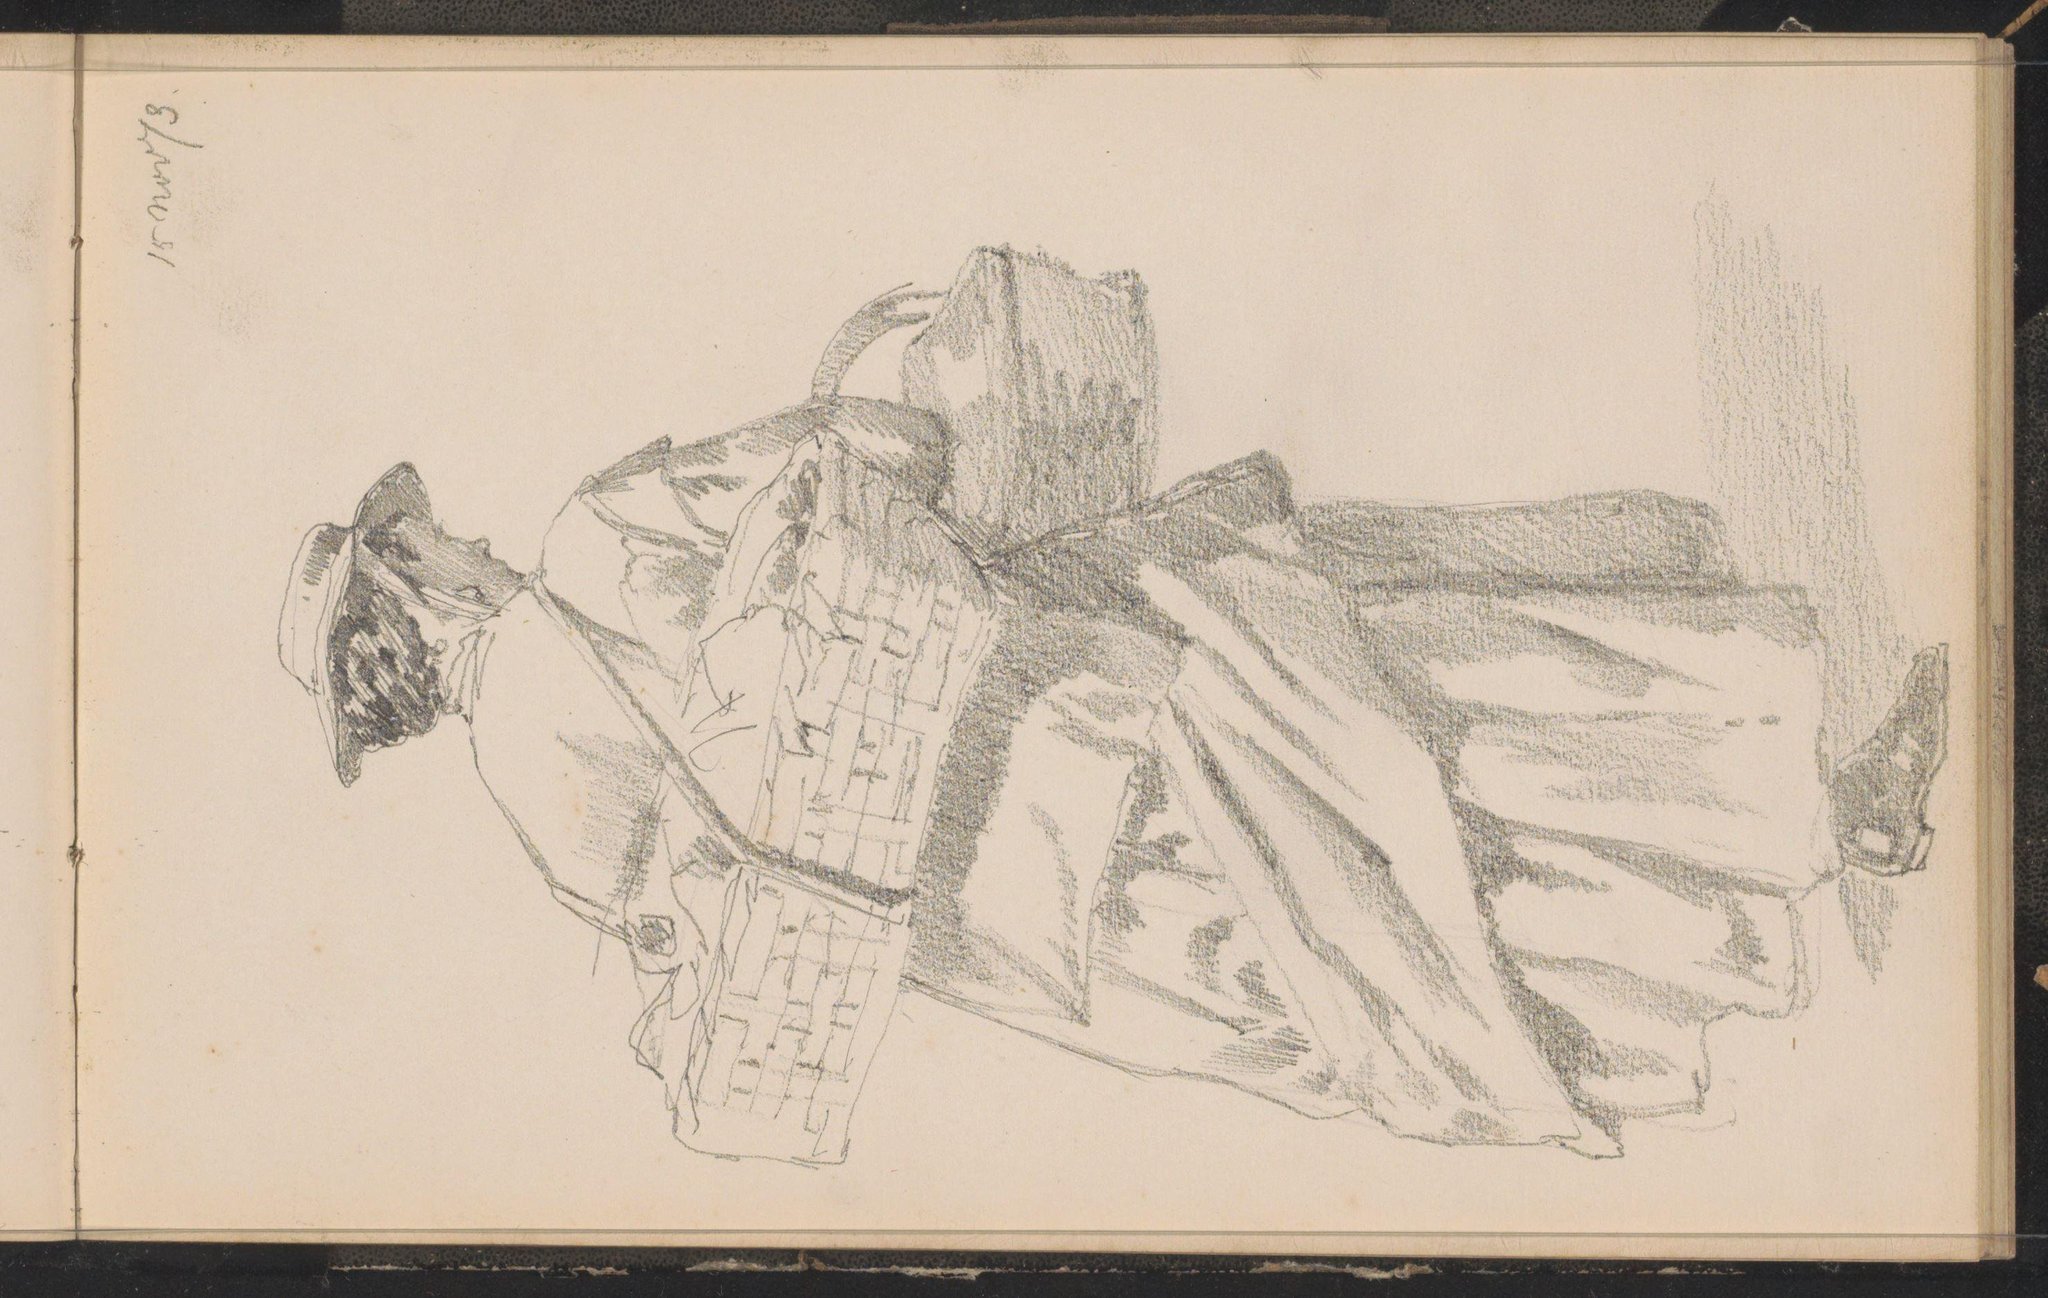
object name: sketchbook leaf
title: Vrouw met twee manden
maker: cornelis springer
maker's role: draughtsman, painter, print maker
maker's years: 1817-1891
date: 1873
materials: paper, pencil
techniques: stumping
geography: netherlands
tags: head-gear: hat (+ women's clothes), container made of plant material other than wood: basket, standing figure - aa - female human figure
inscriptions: date: ‘15 nov 73’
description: Vrouw met een hoed. Ze draagt een mand op haar rug en een mand aan haar arm. Blad 27 uit een schetsboek met 46 bladen.